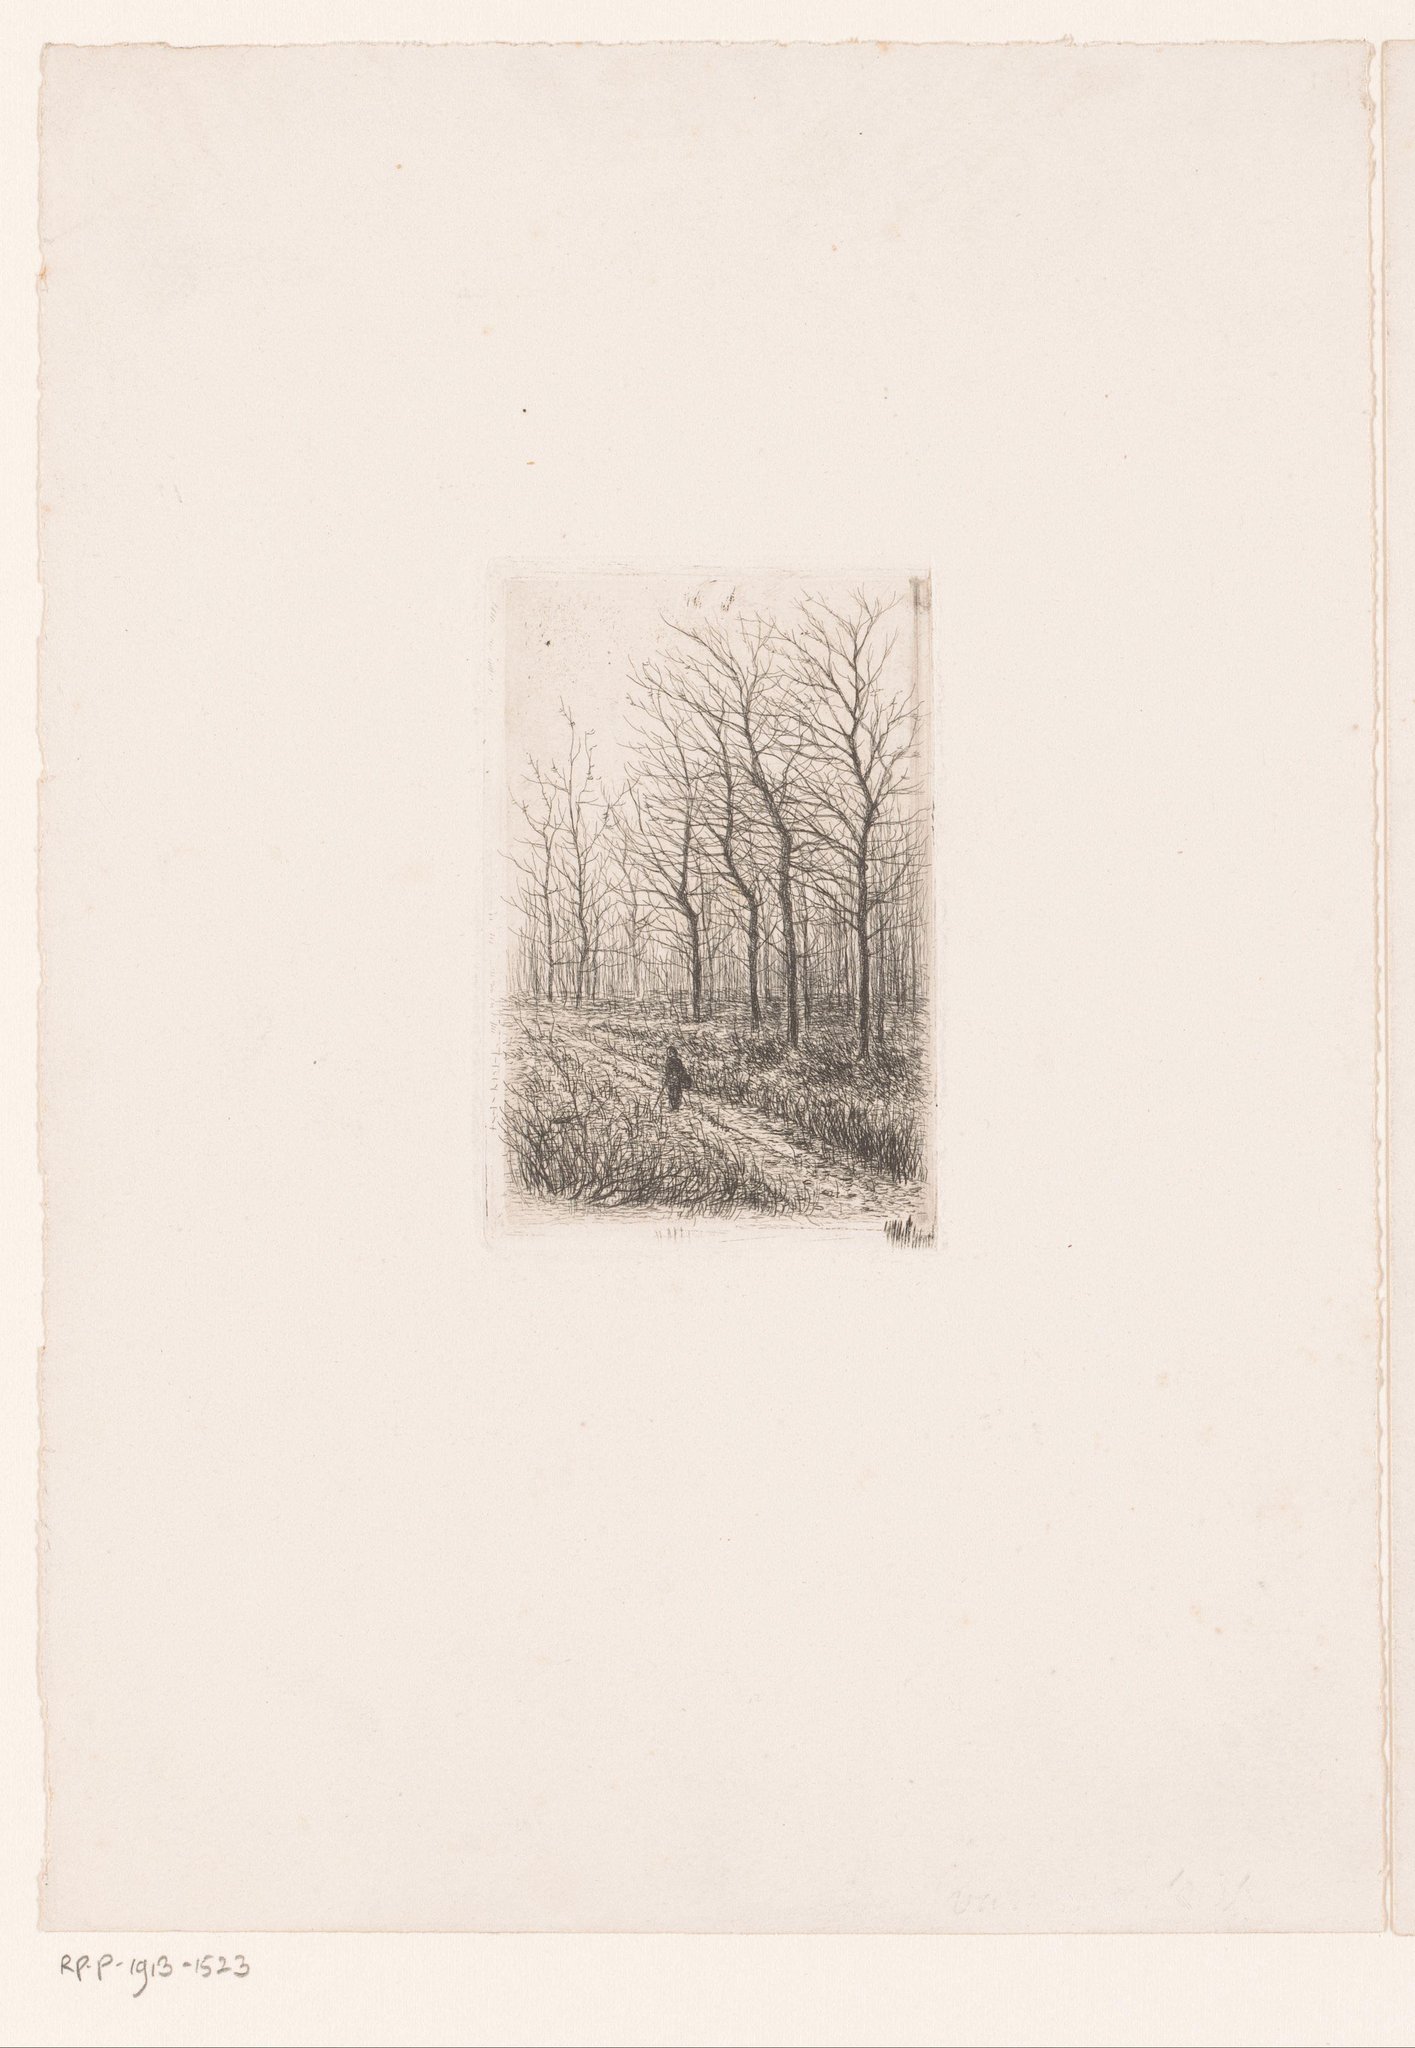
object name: print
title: Wandelaar op een bospad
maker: h. van meerbeeck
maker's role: print maker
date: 1850-1913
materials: paper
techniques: etching, intaglio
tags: walking-stick, staff, walking, forest path or lane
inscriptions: collector's mark: Lugt 2228